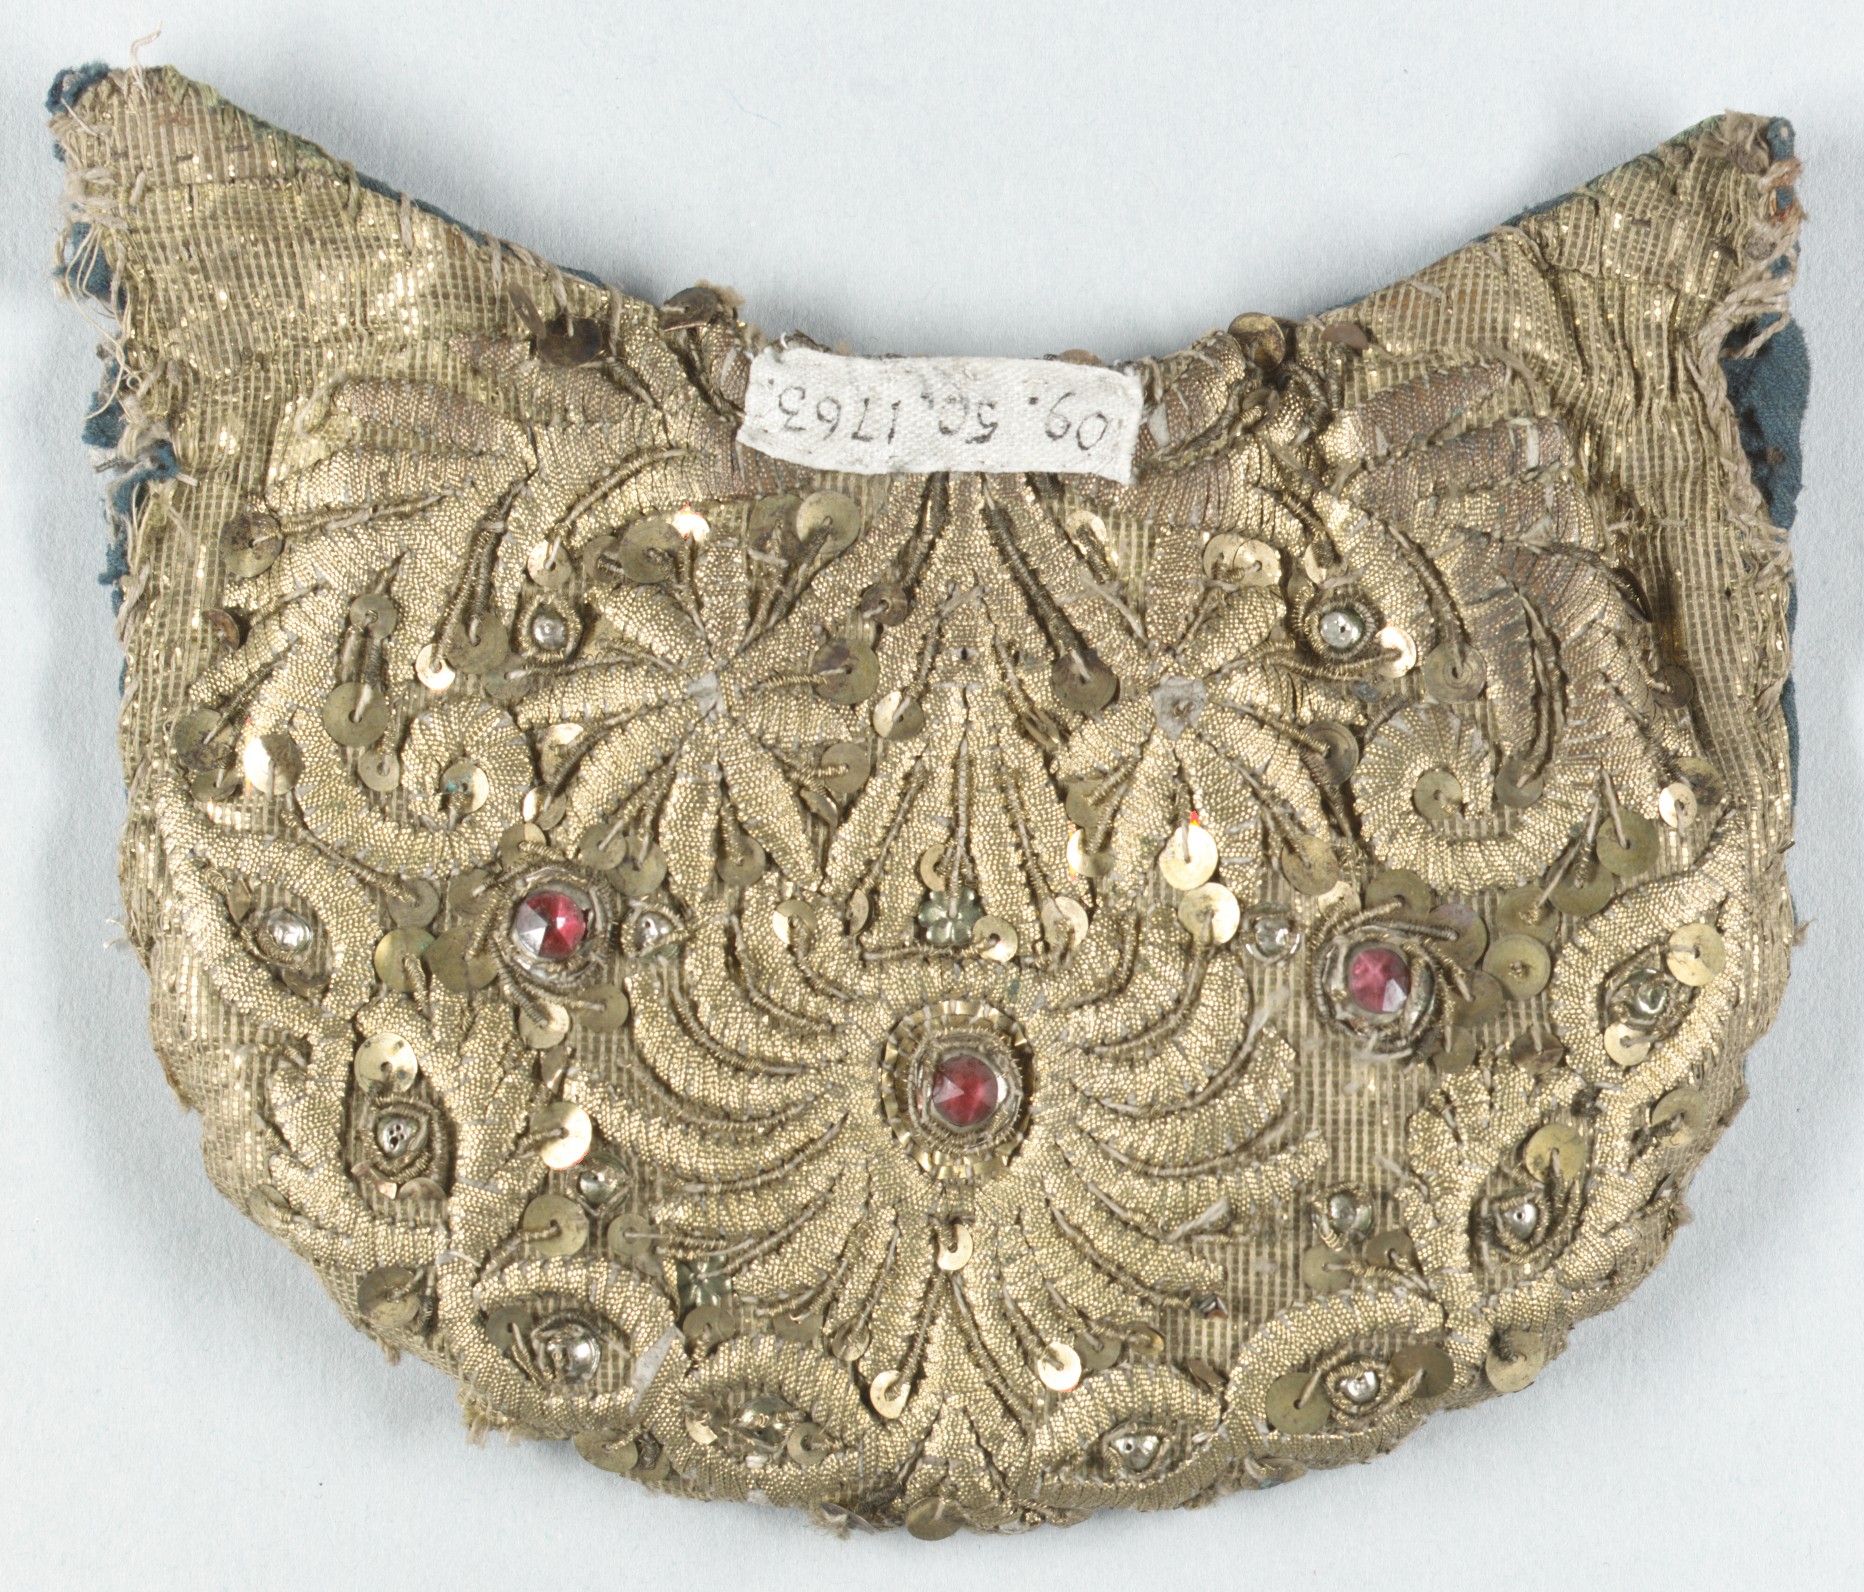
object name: cap crown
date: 1801-1900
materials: metal thread